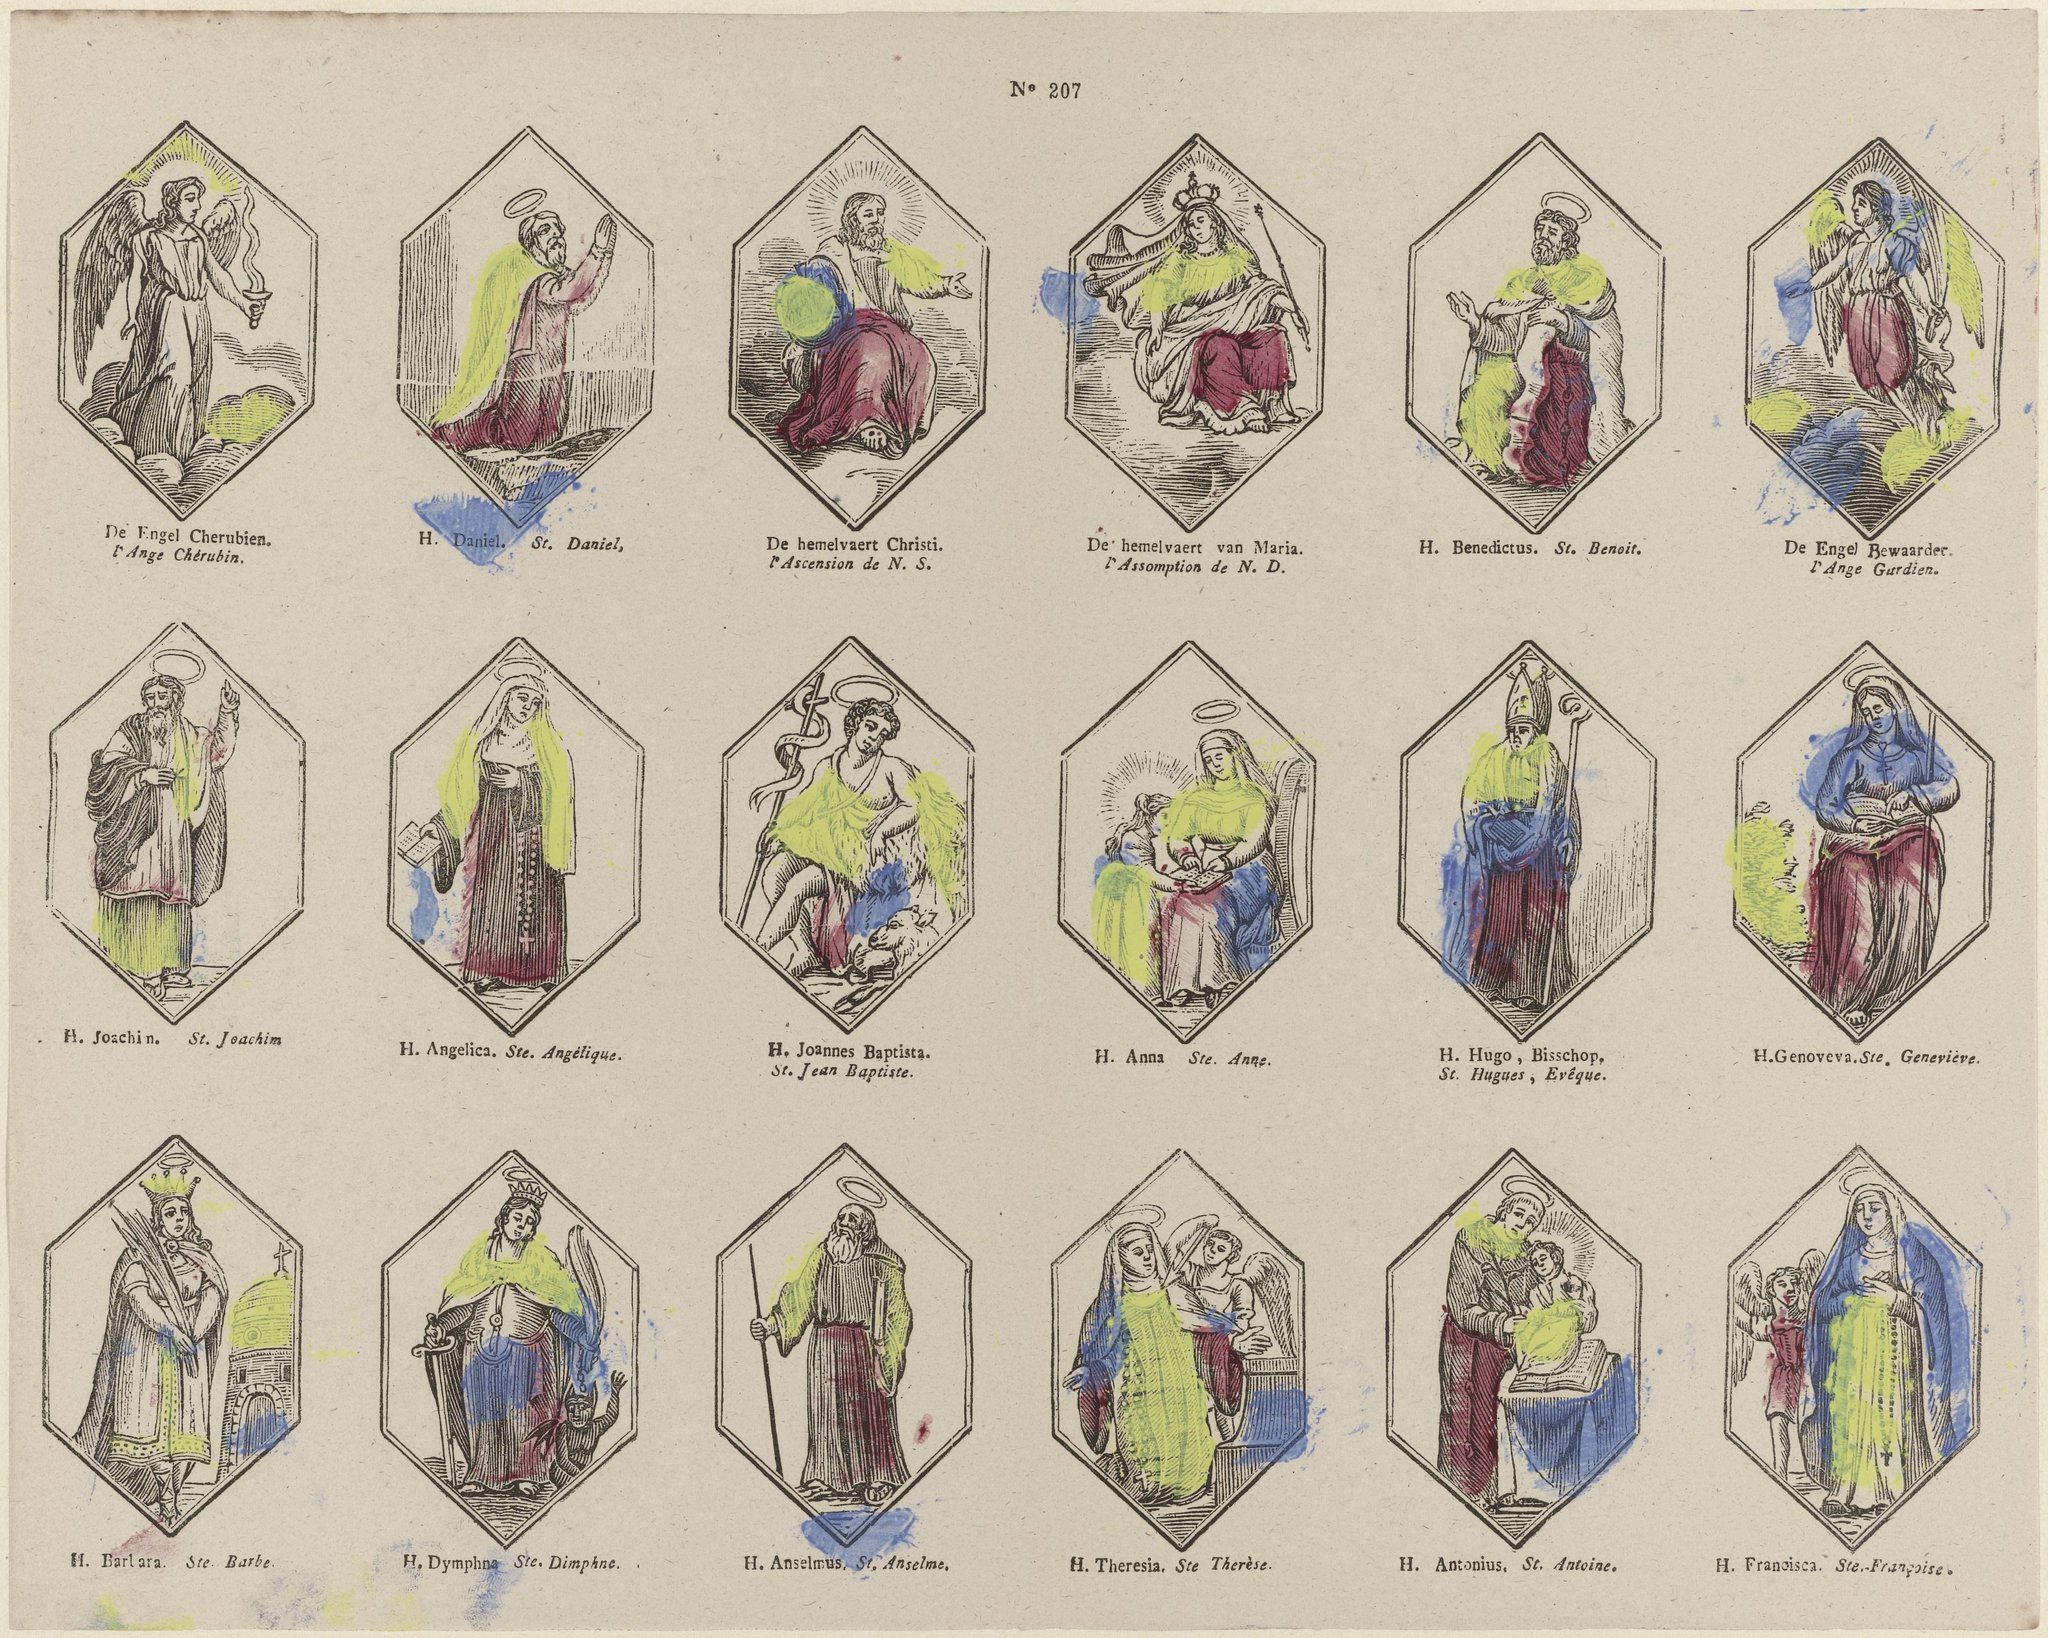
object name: popular print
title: Heiligen en engelen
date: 1800-1833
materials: paper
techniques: colour, letterpress printing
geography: turnhout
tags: benedict of nurcia, abbot of monte cassino and founder of the benedictine order; possible attributes: aspergillum, book, cup (sometimes broken), raven with loaf, sieve (or tray), saints, anna, mother of mary; possible attributes: book, christ-child, lily, virgin mary, series of scenes from the life of john the baptist, the franciscan monk antony of padua; possible attributes: ass, book, crucifix, flowered cross, flaming heart, infant christ (on book), lily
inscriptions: collector's mark: Lugt 2760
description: Blad met 18 voorstellingen van heiligen en engelen, waaronder St. Daniël, St. Benedictus, St. Anna en St. Antonius. Onder elke voorstelling een onderschrift. Genummerd midden boven: No. 207.